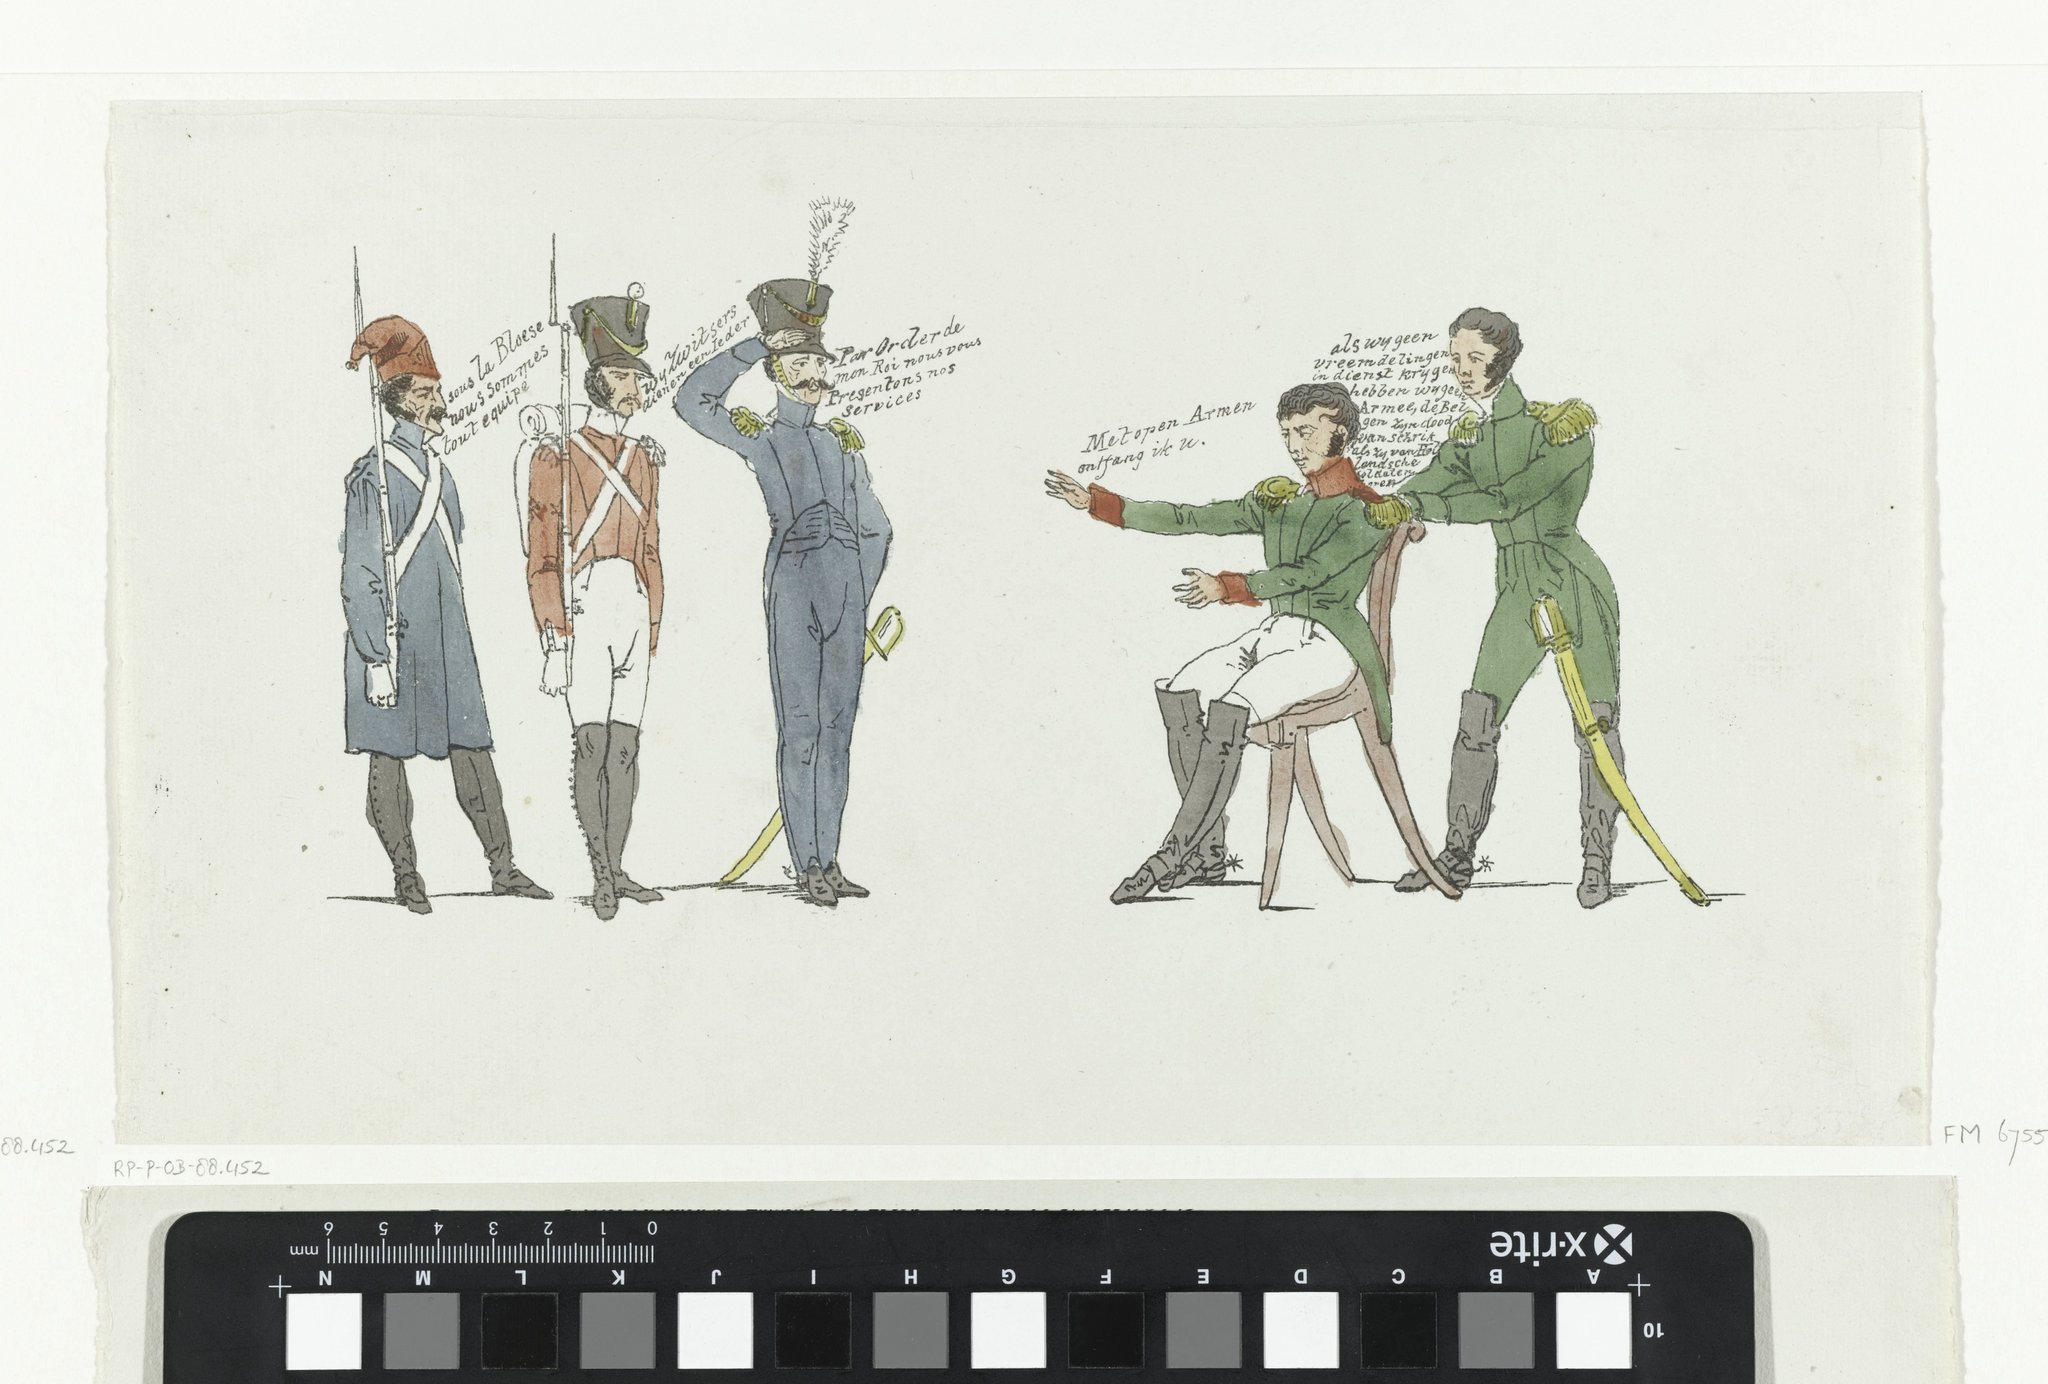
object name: cartoon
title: Spotprent op werven van buitenlandse militairen door België, 1831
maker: Anonymous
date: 1831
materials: paper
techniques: hand coloring, lithograph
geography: netherlands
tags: leopold i (koning der belgen), recruitment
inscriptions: collector's mark: Lugt 2228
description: Spotprent op het werven van buitenlandse militairen door België, 1831. De Belgische koning Leopold I zittend in een stoel verwelkomt met open armen drie buitenlandse militairen, waaronder een Fransman en een Zwitser.